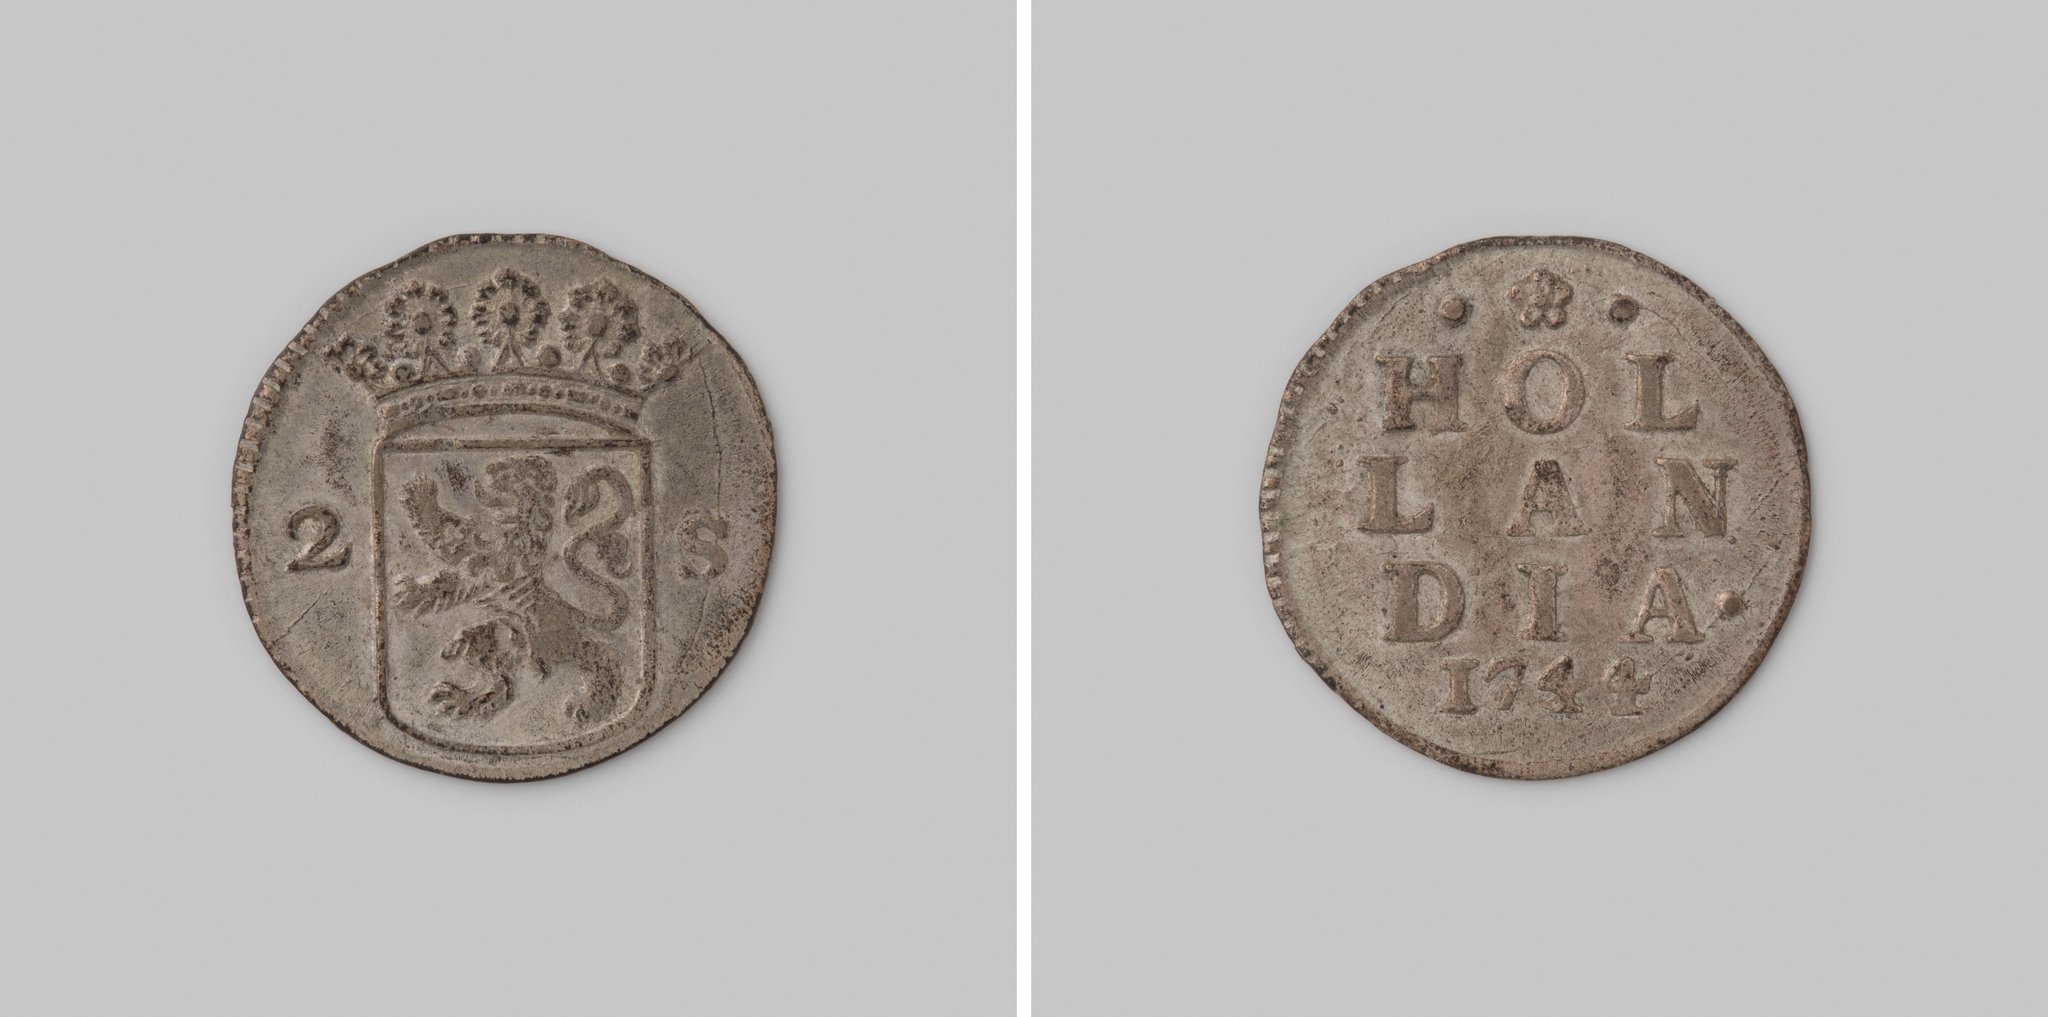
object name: coin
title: Holland, dubbele stuiver, 1744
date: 1744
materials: silver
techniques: striking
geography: dordrecht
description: Zilveren munt. Voorzijde: tussen waarde-aanduiding 2 S gekroond wapenschild van Holland. Keerzijde: opschrift: provincienaam in drie regels, daaronder jaartal.